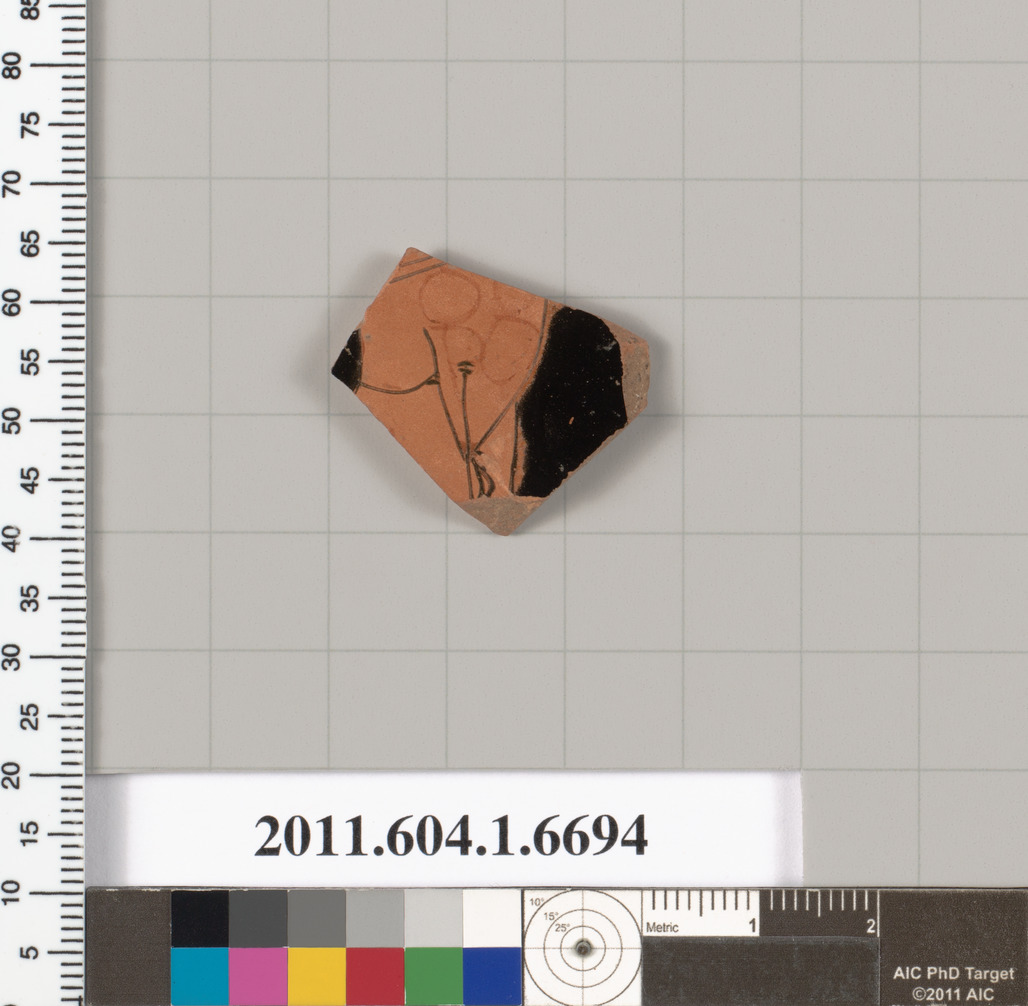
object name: kylix fragment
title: Terracotta fragment of a kylix (drinking cup)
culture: greek, attic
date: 490-470 BCE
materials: terracotta